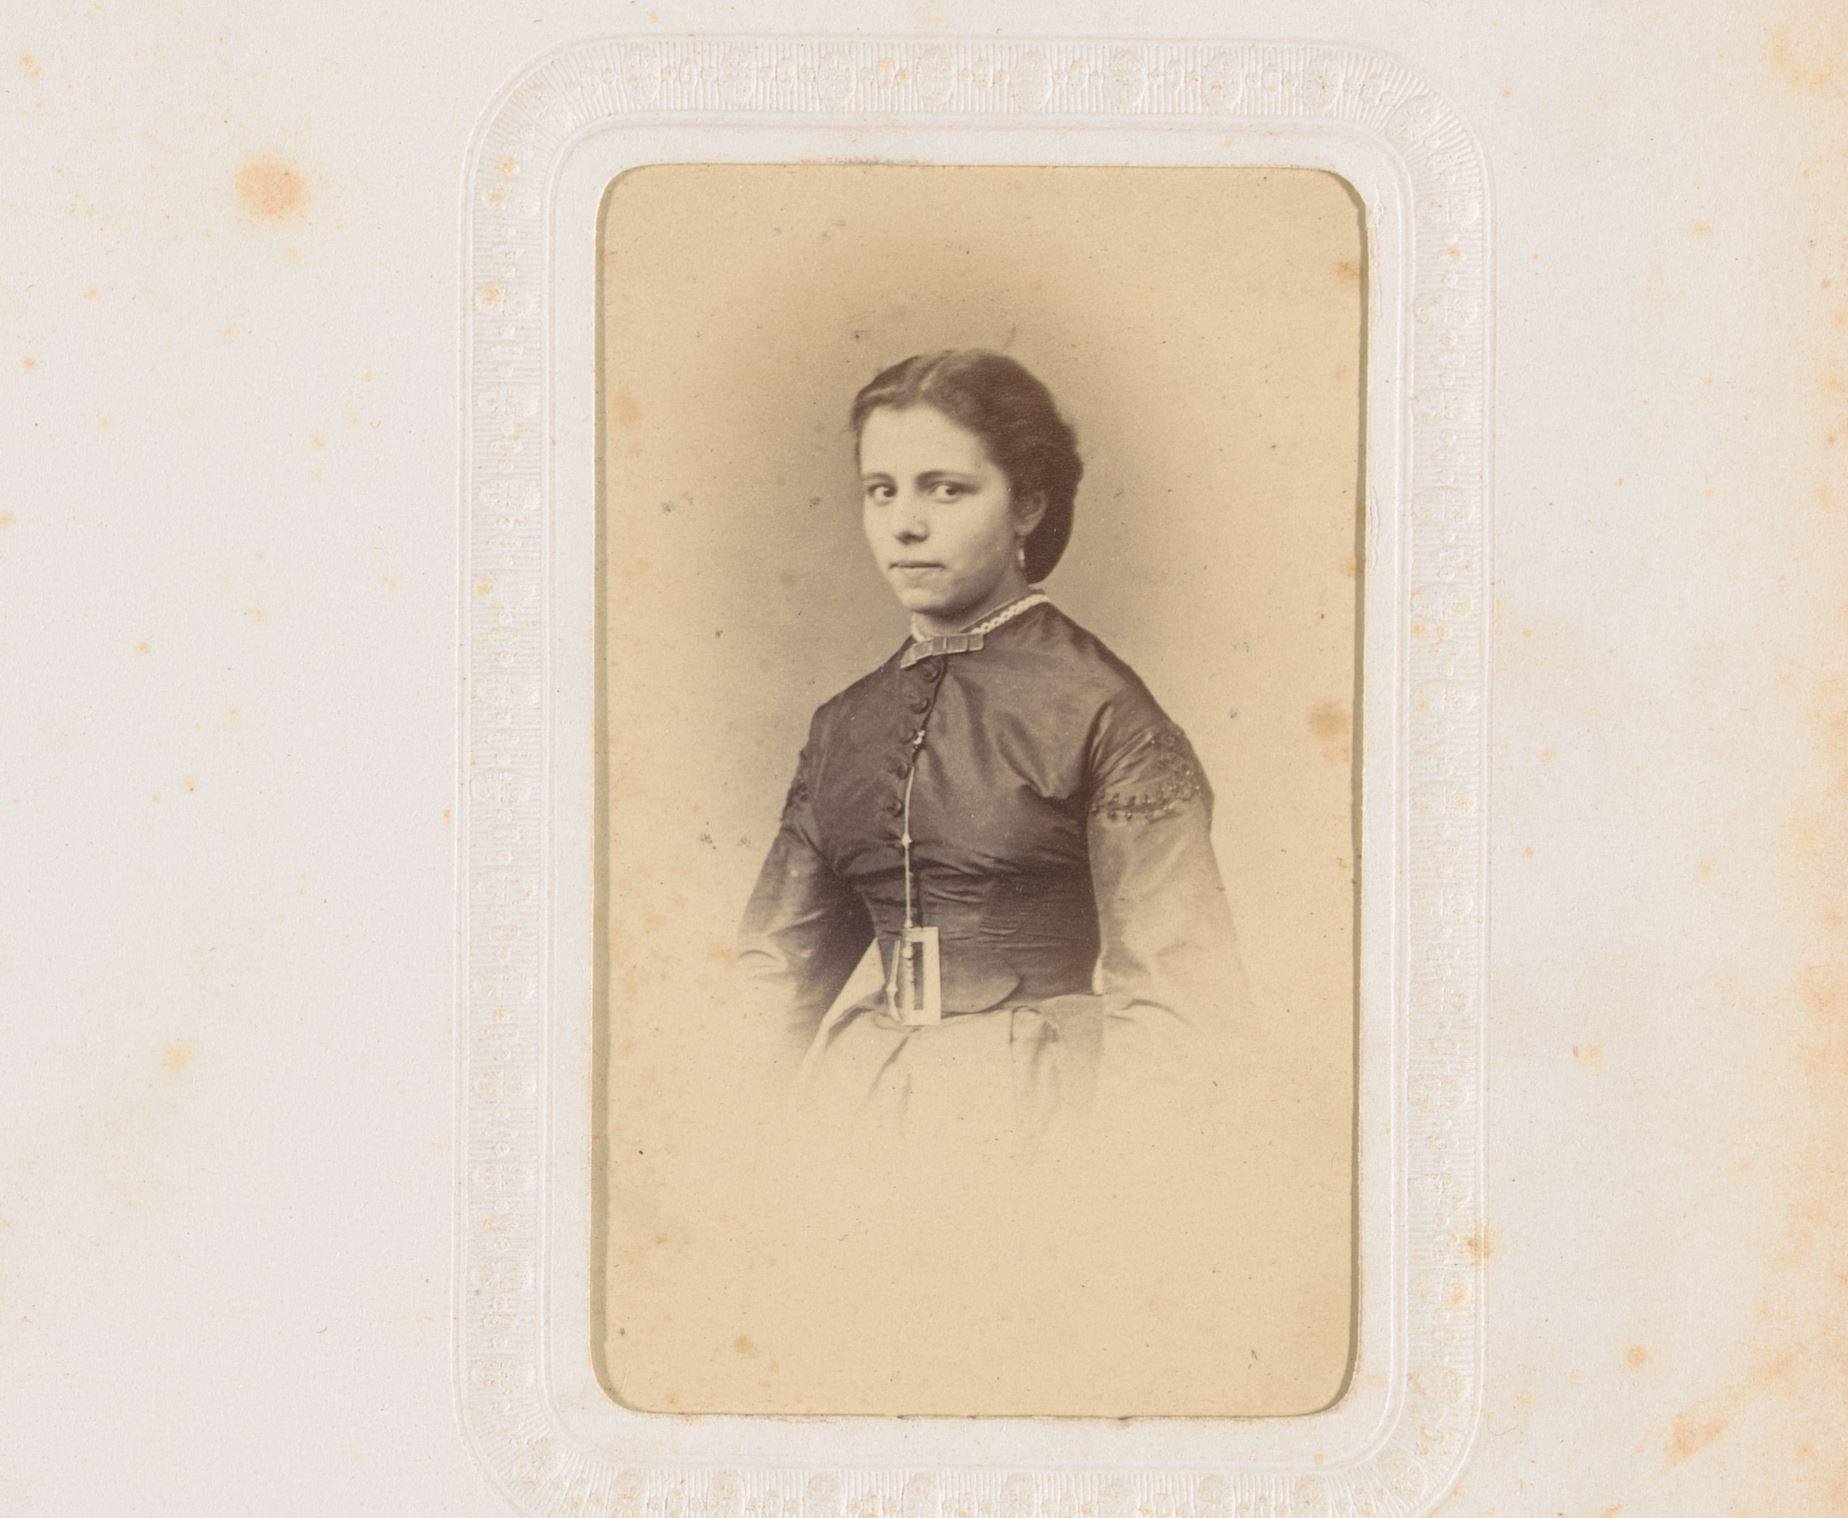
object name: carte de visite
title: Portret van een jonge vrouw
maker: Anonymous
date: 1860-1900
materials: cardboard, photographic support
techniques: albumen print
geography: netherlands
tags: adolescent, young woman, maiden, historical persons - bb - woman